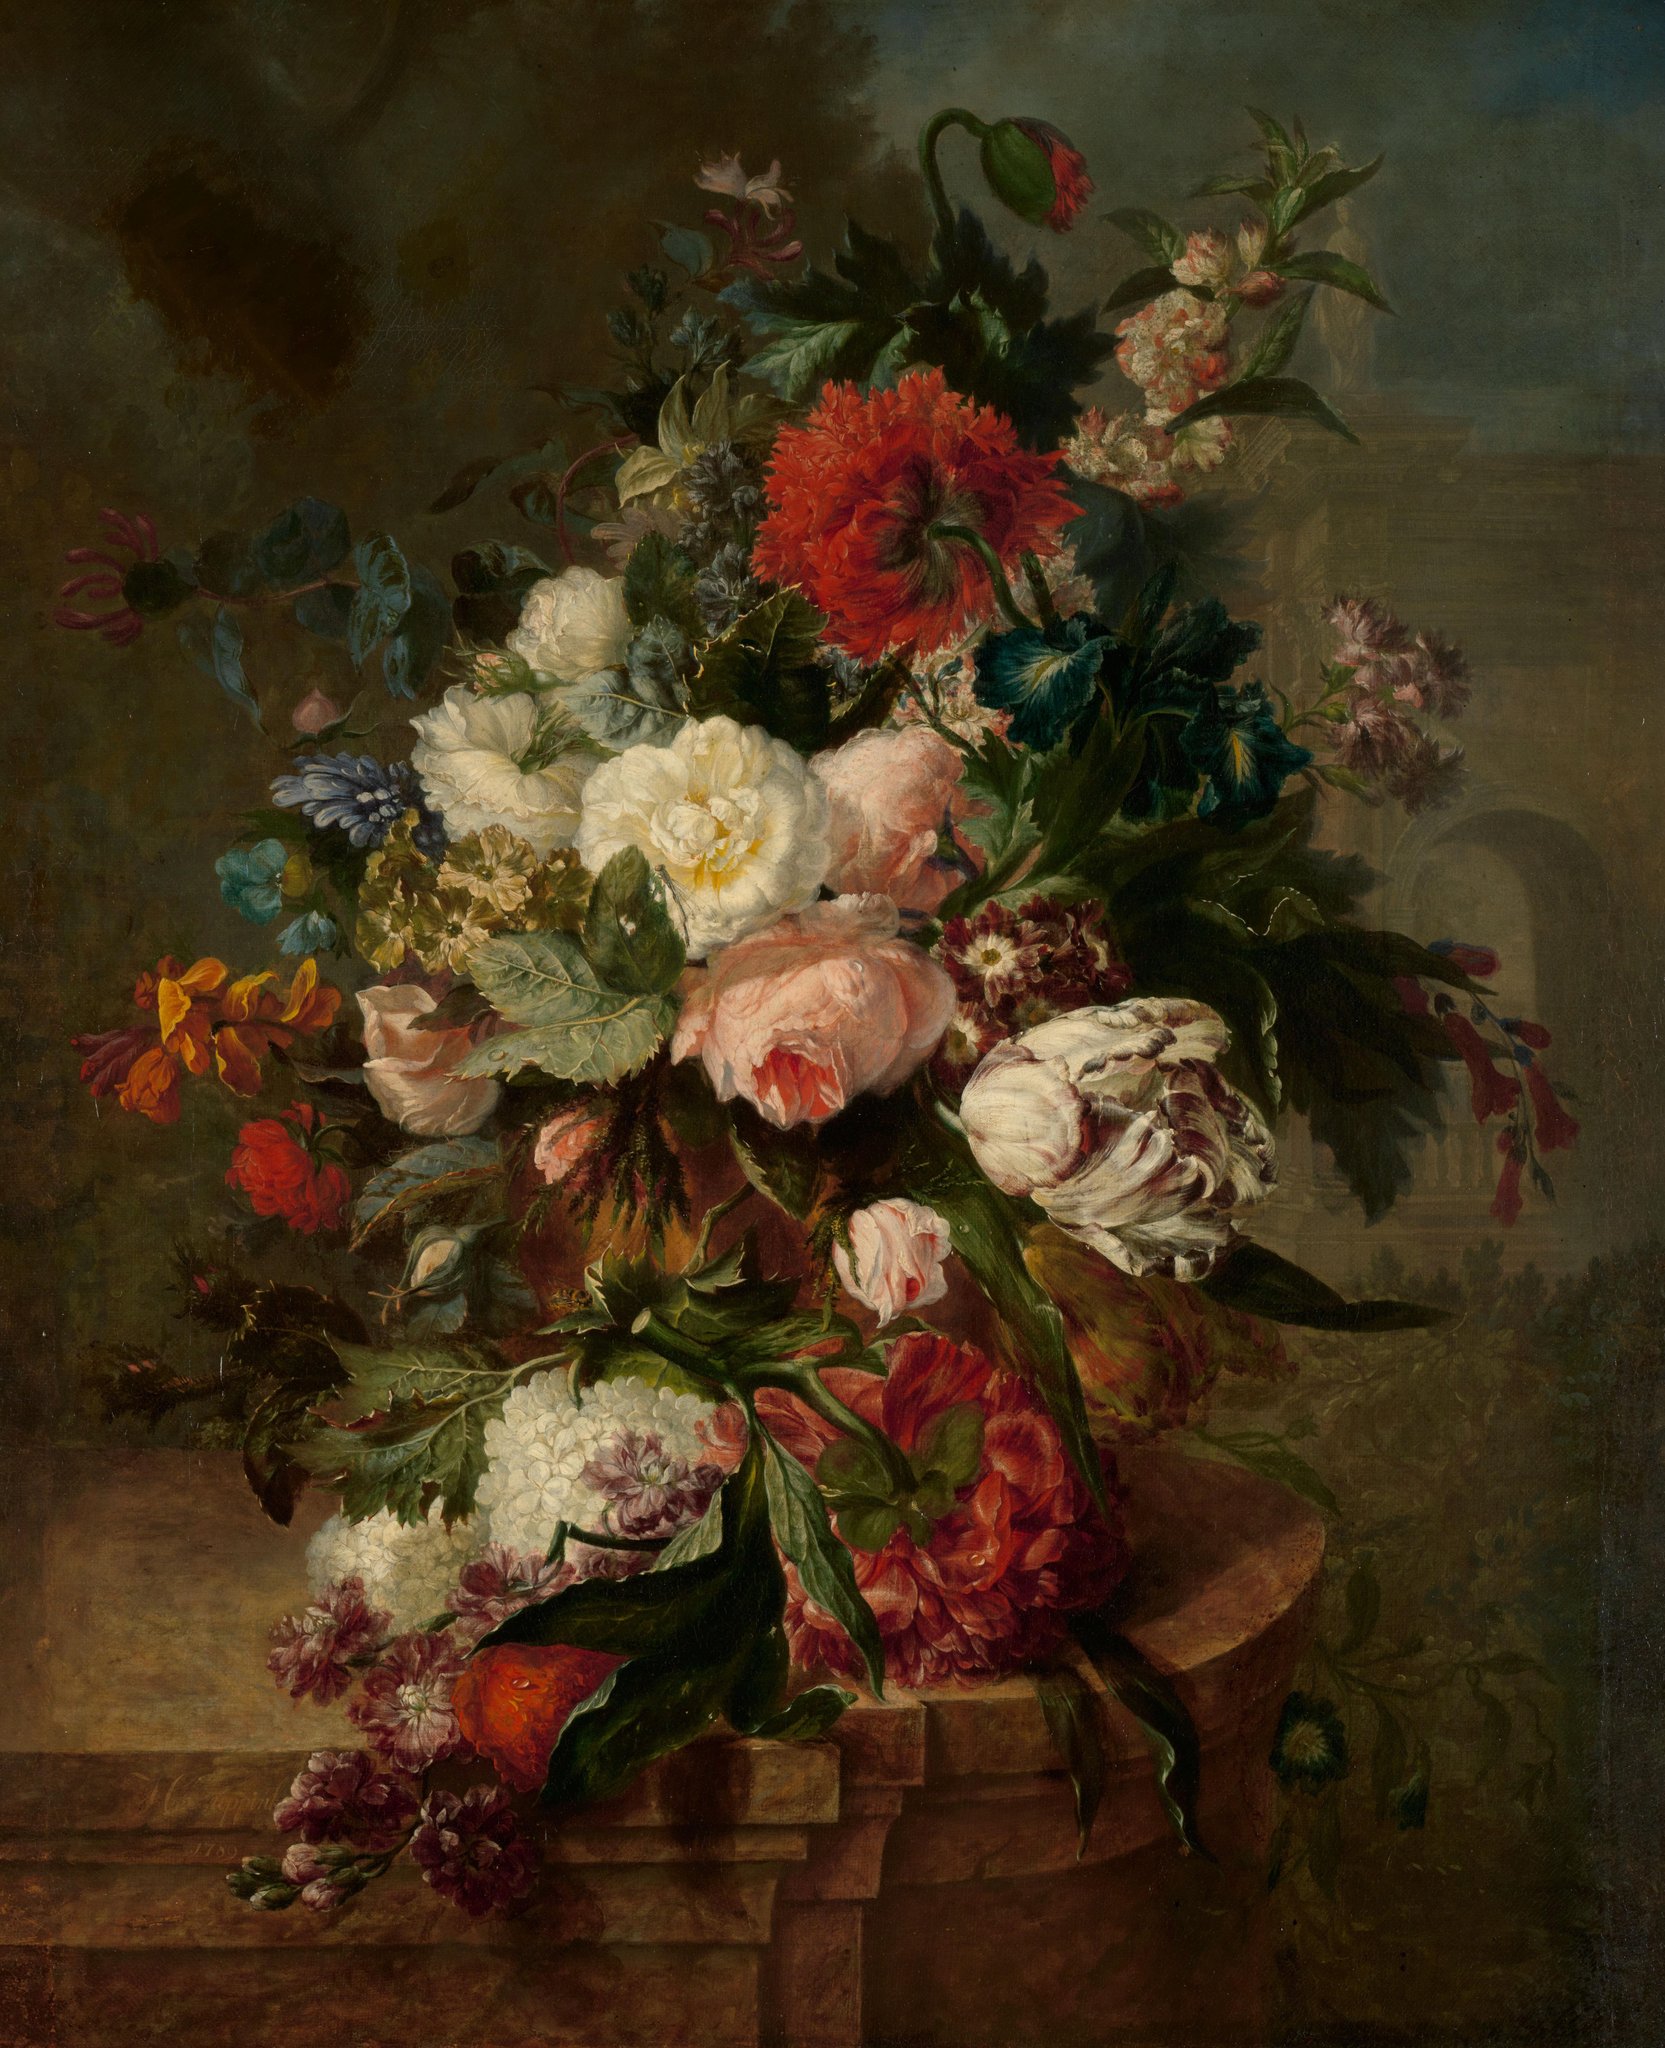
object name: painting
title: Still Life with Flowers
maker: harmanus uppink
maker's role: draughtsman, painter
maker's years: 1765-1791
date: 1789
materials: canvas, oil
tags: flowers, cut flowers; nosegay, bunch of flowers, still life of related objects, flowers in a vase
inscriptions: signature and date: ‘Hs. Uppink 1789’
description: Stilleven met bloemen. Bloemstuk met tulpen, anjers, rozen, papavers, kamperfoelie en irissen, op de achtergrond een landschap met een boog.